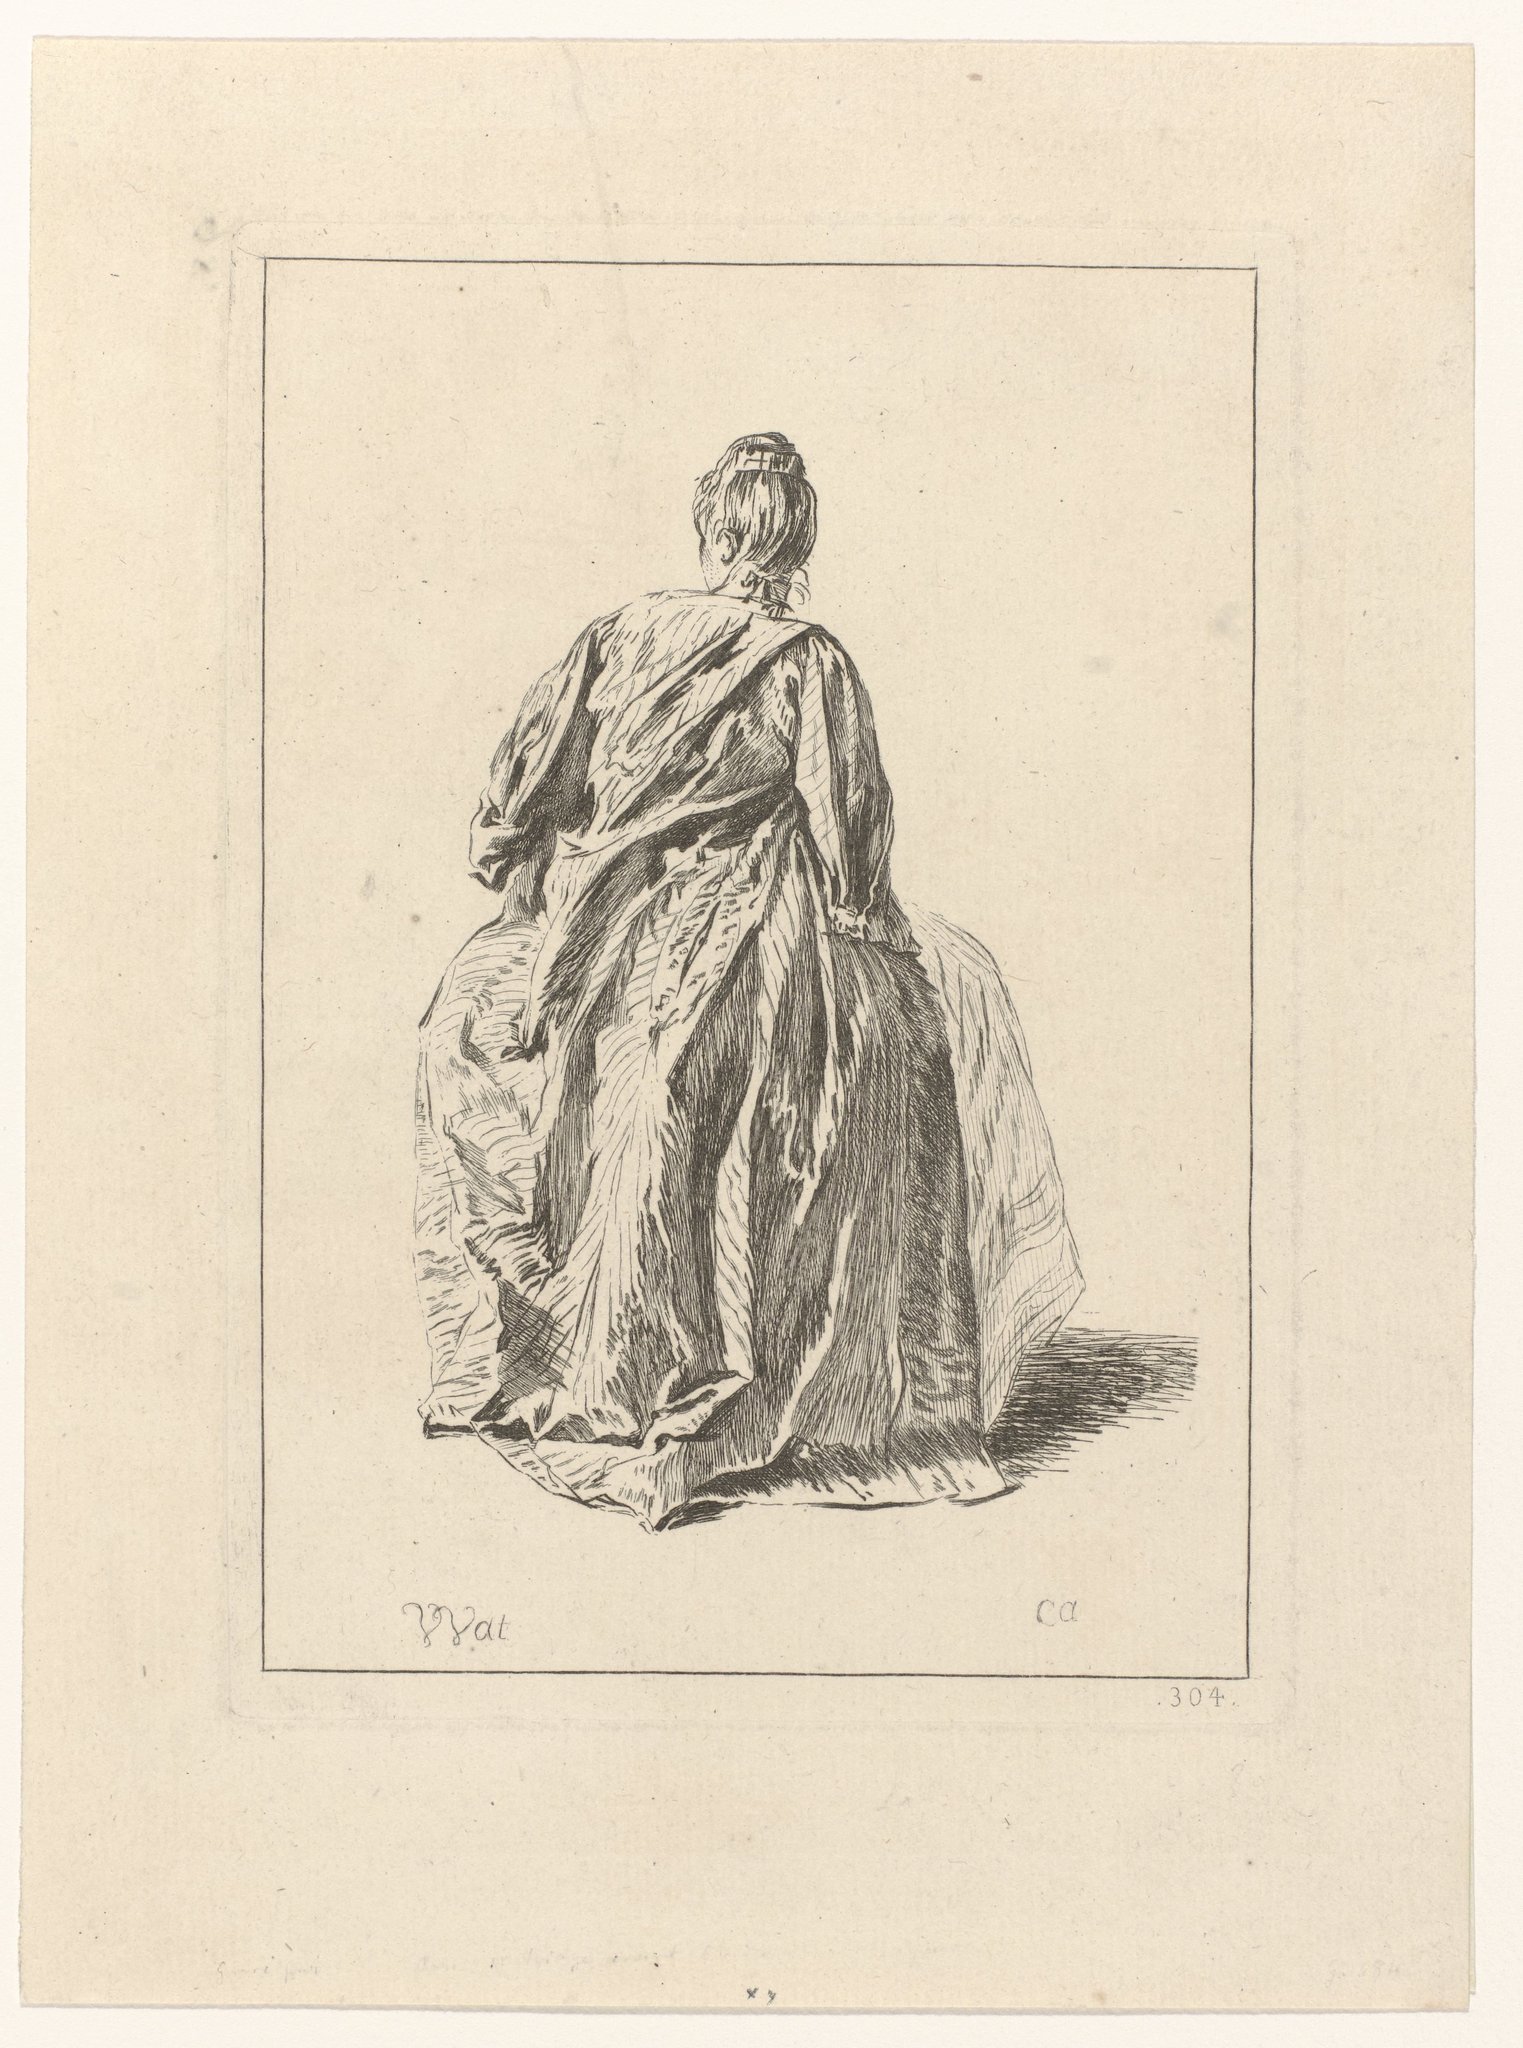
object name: costume print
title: Zittende vrouw op de rug gezien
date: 1702-1765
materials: paper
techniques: etching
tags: dress, gown: robe volante (+ women's clothes), fashion plates, skirt (+ women's clothes)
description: Zittende vrouw op de rug gezien. Zij draagt een losvallende mantel of japon om de schouders. De prent maakt deel uit van een serie van vijf kostuumprenten.